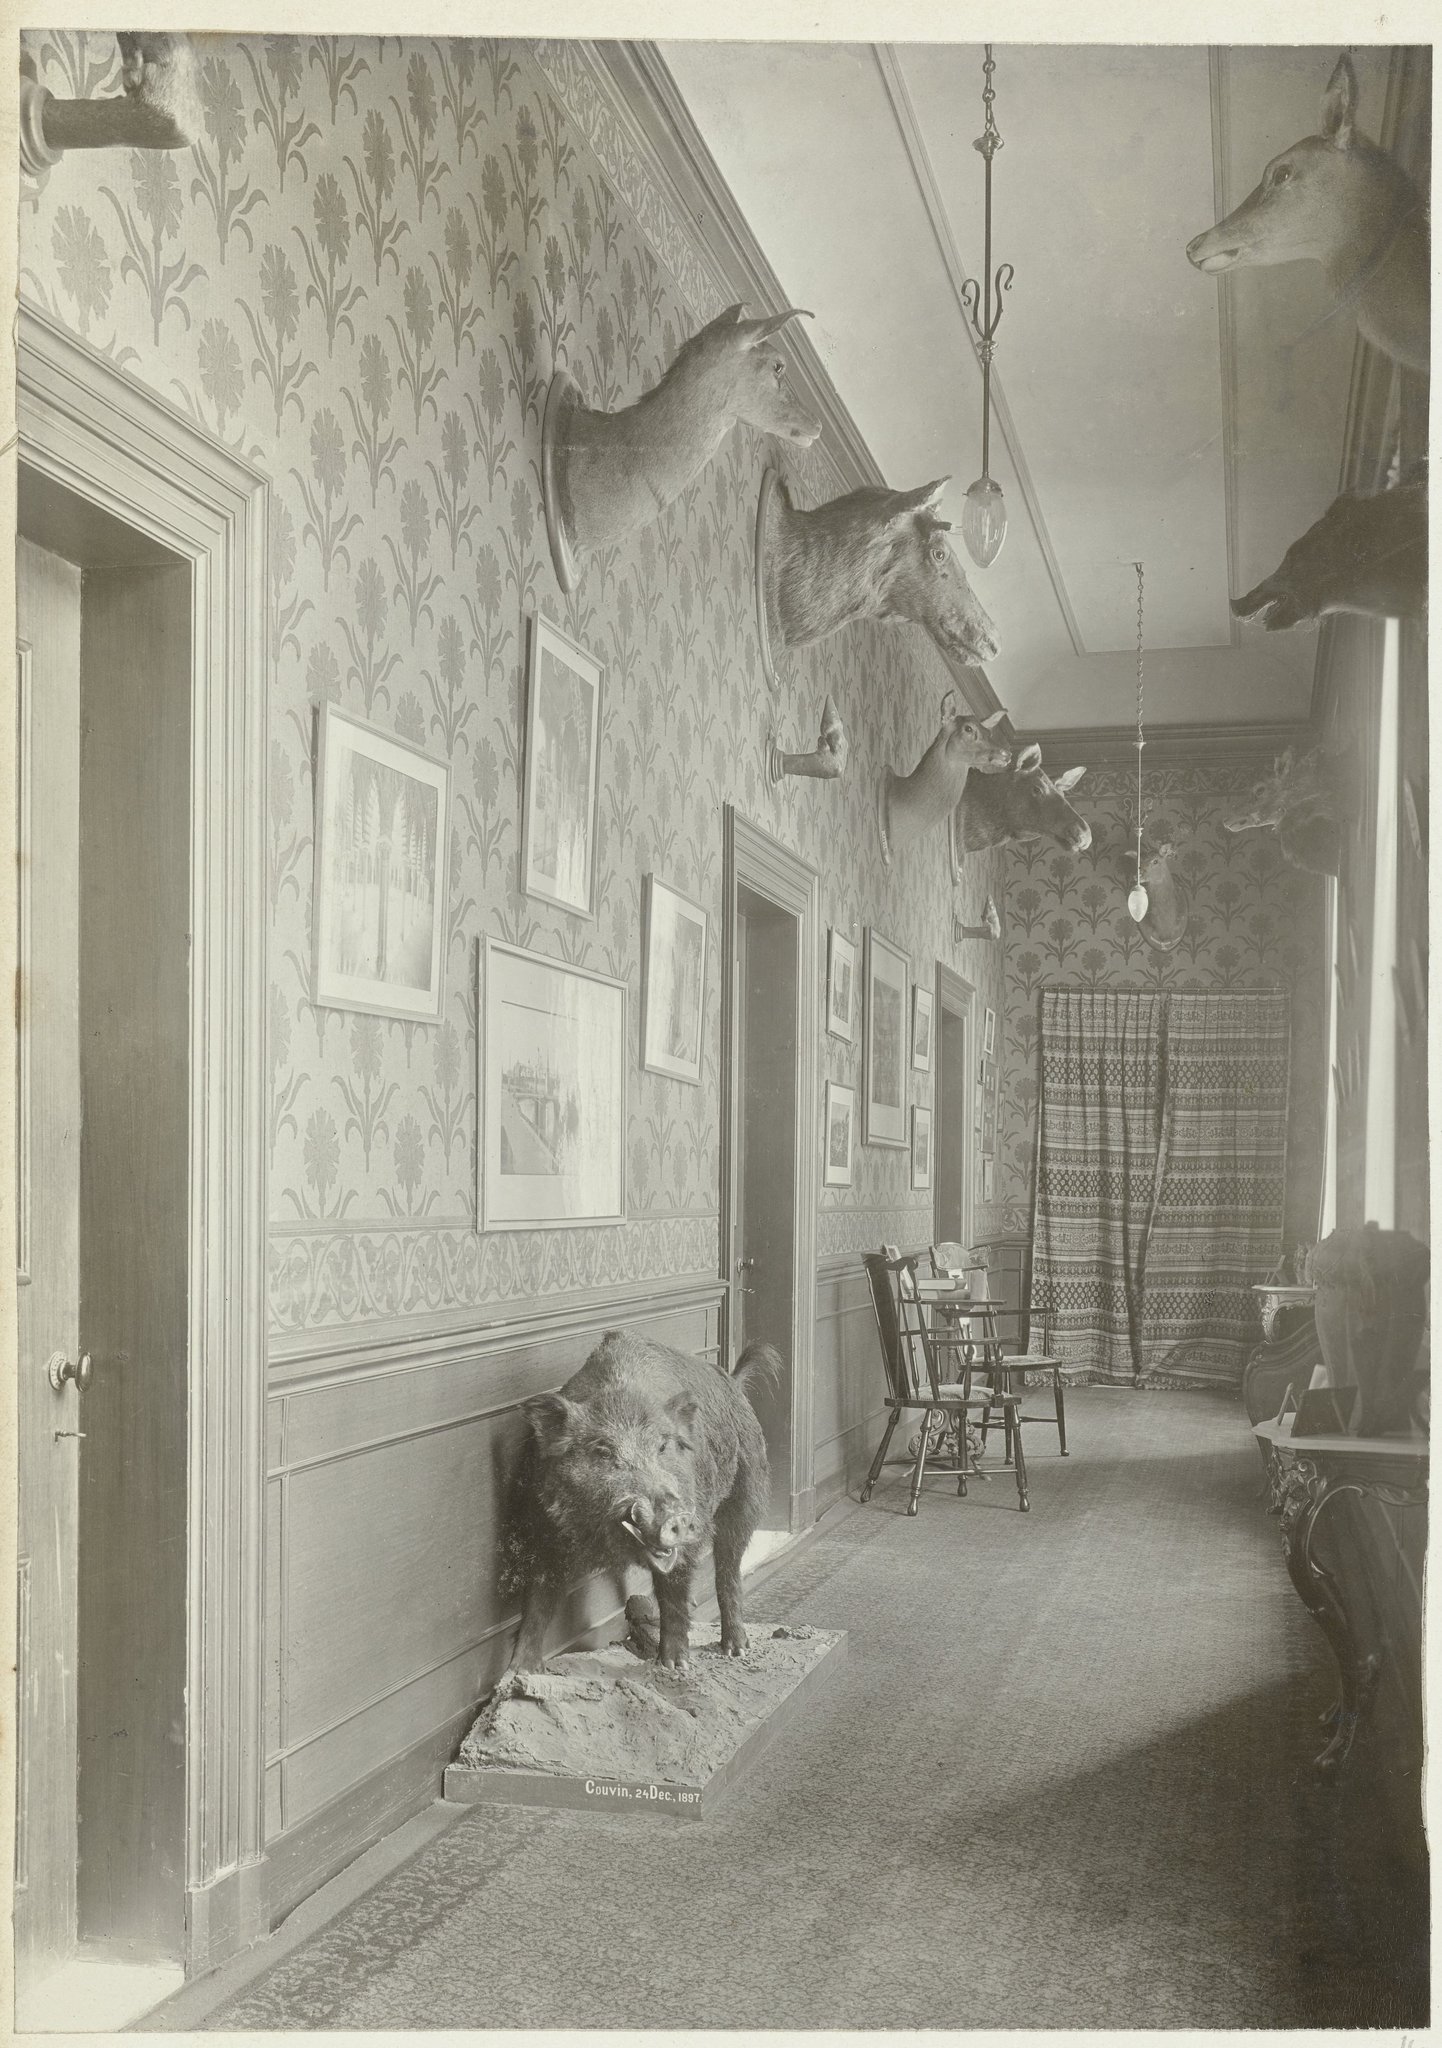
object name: photograph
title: Hal van landhuis De Wildbaan, Driebergen, met jachttrofeeën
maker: henry pauw van wieldrecht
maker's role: fotograaf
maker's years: 1863-1912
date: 1903-1907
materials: paper, photographic support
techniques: gelatin silver print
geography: netherlands